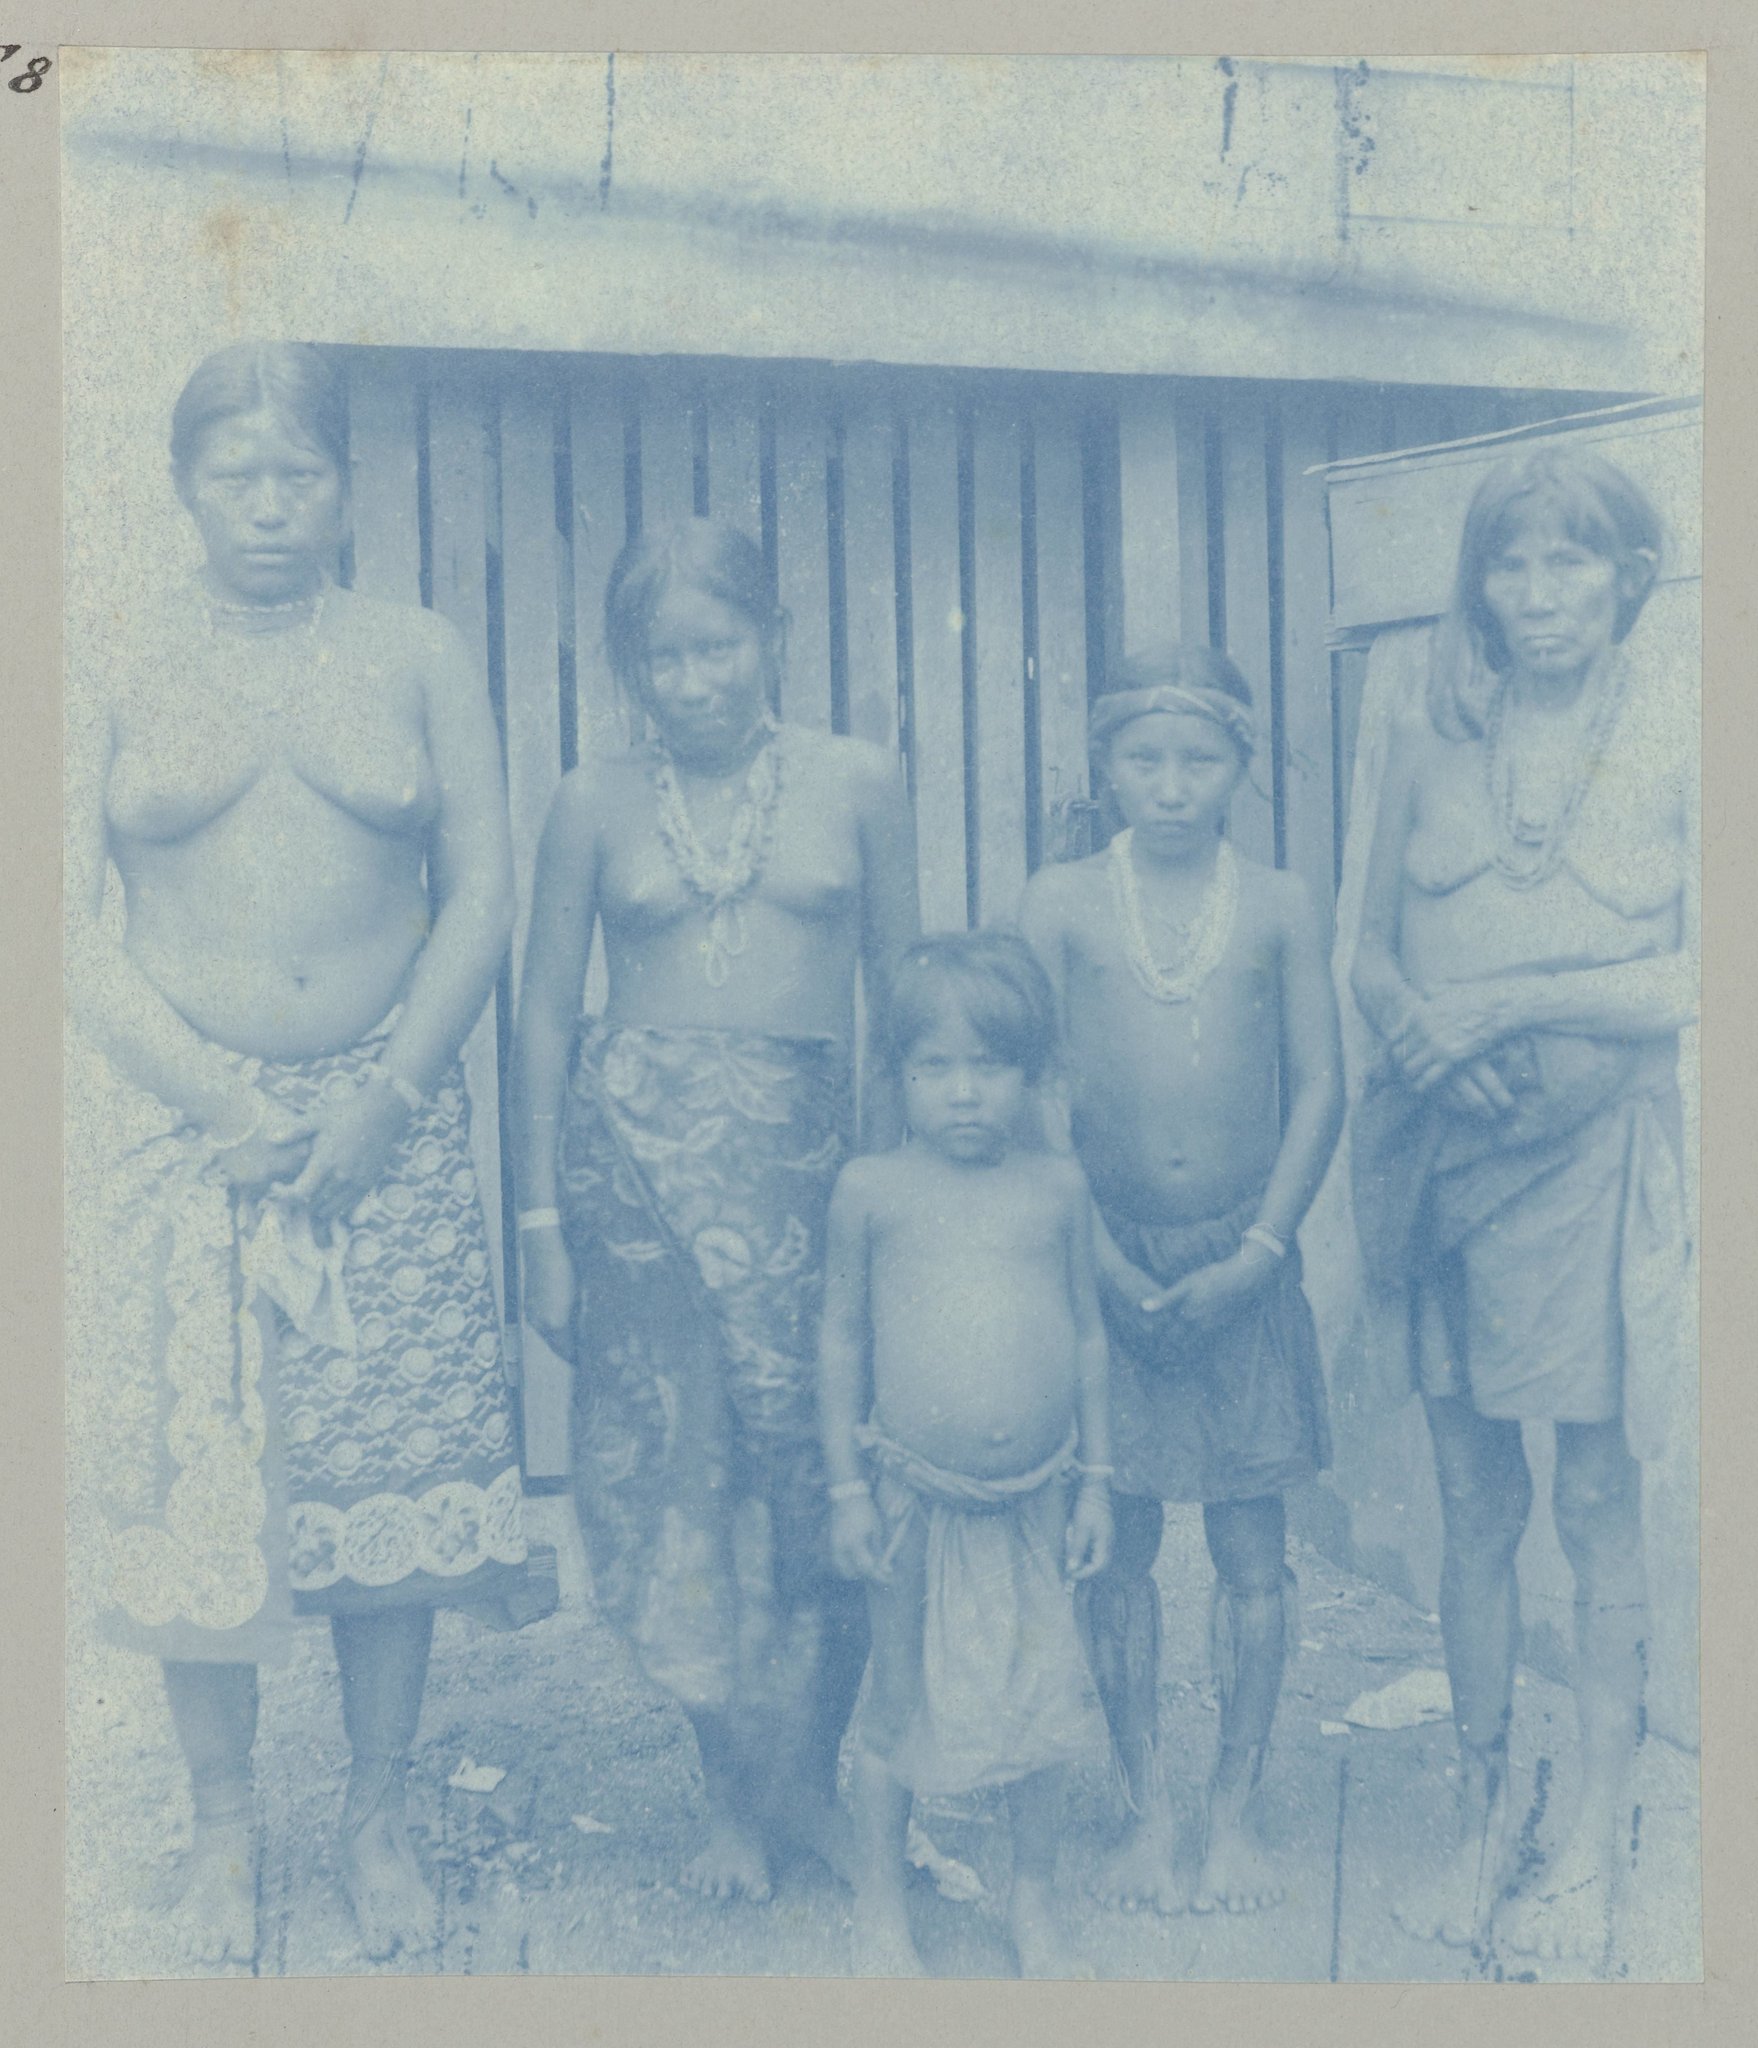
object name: photograph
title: Surinaamse Caraïben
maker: hendrik doijer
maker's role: engineer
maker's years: 1863-1925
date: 1903-1910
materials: photographic support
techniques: cyanotype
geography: suriname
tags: indigenous peoples of south america, suriname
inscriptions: inscription: ‘E8 / Caräiben.’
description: Een poserende groep Surinaamse Indiaanse Karaïben; vrouwen, halfnaakt, variërend in leeftijd van jong tot oud. Onderdeel van het fotoalbum Souvenir de Voyage (deel 4), over het leven van de familie Doijer in en rond de plantage Ma Retraite in Suriname in de jaren 1903-1910.